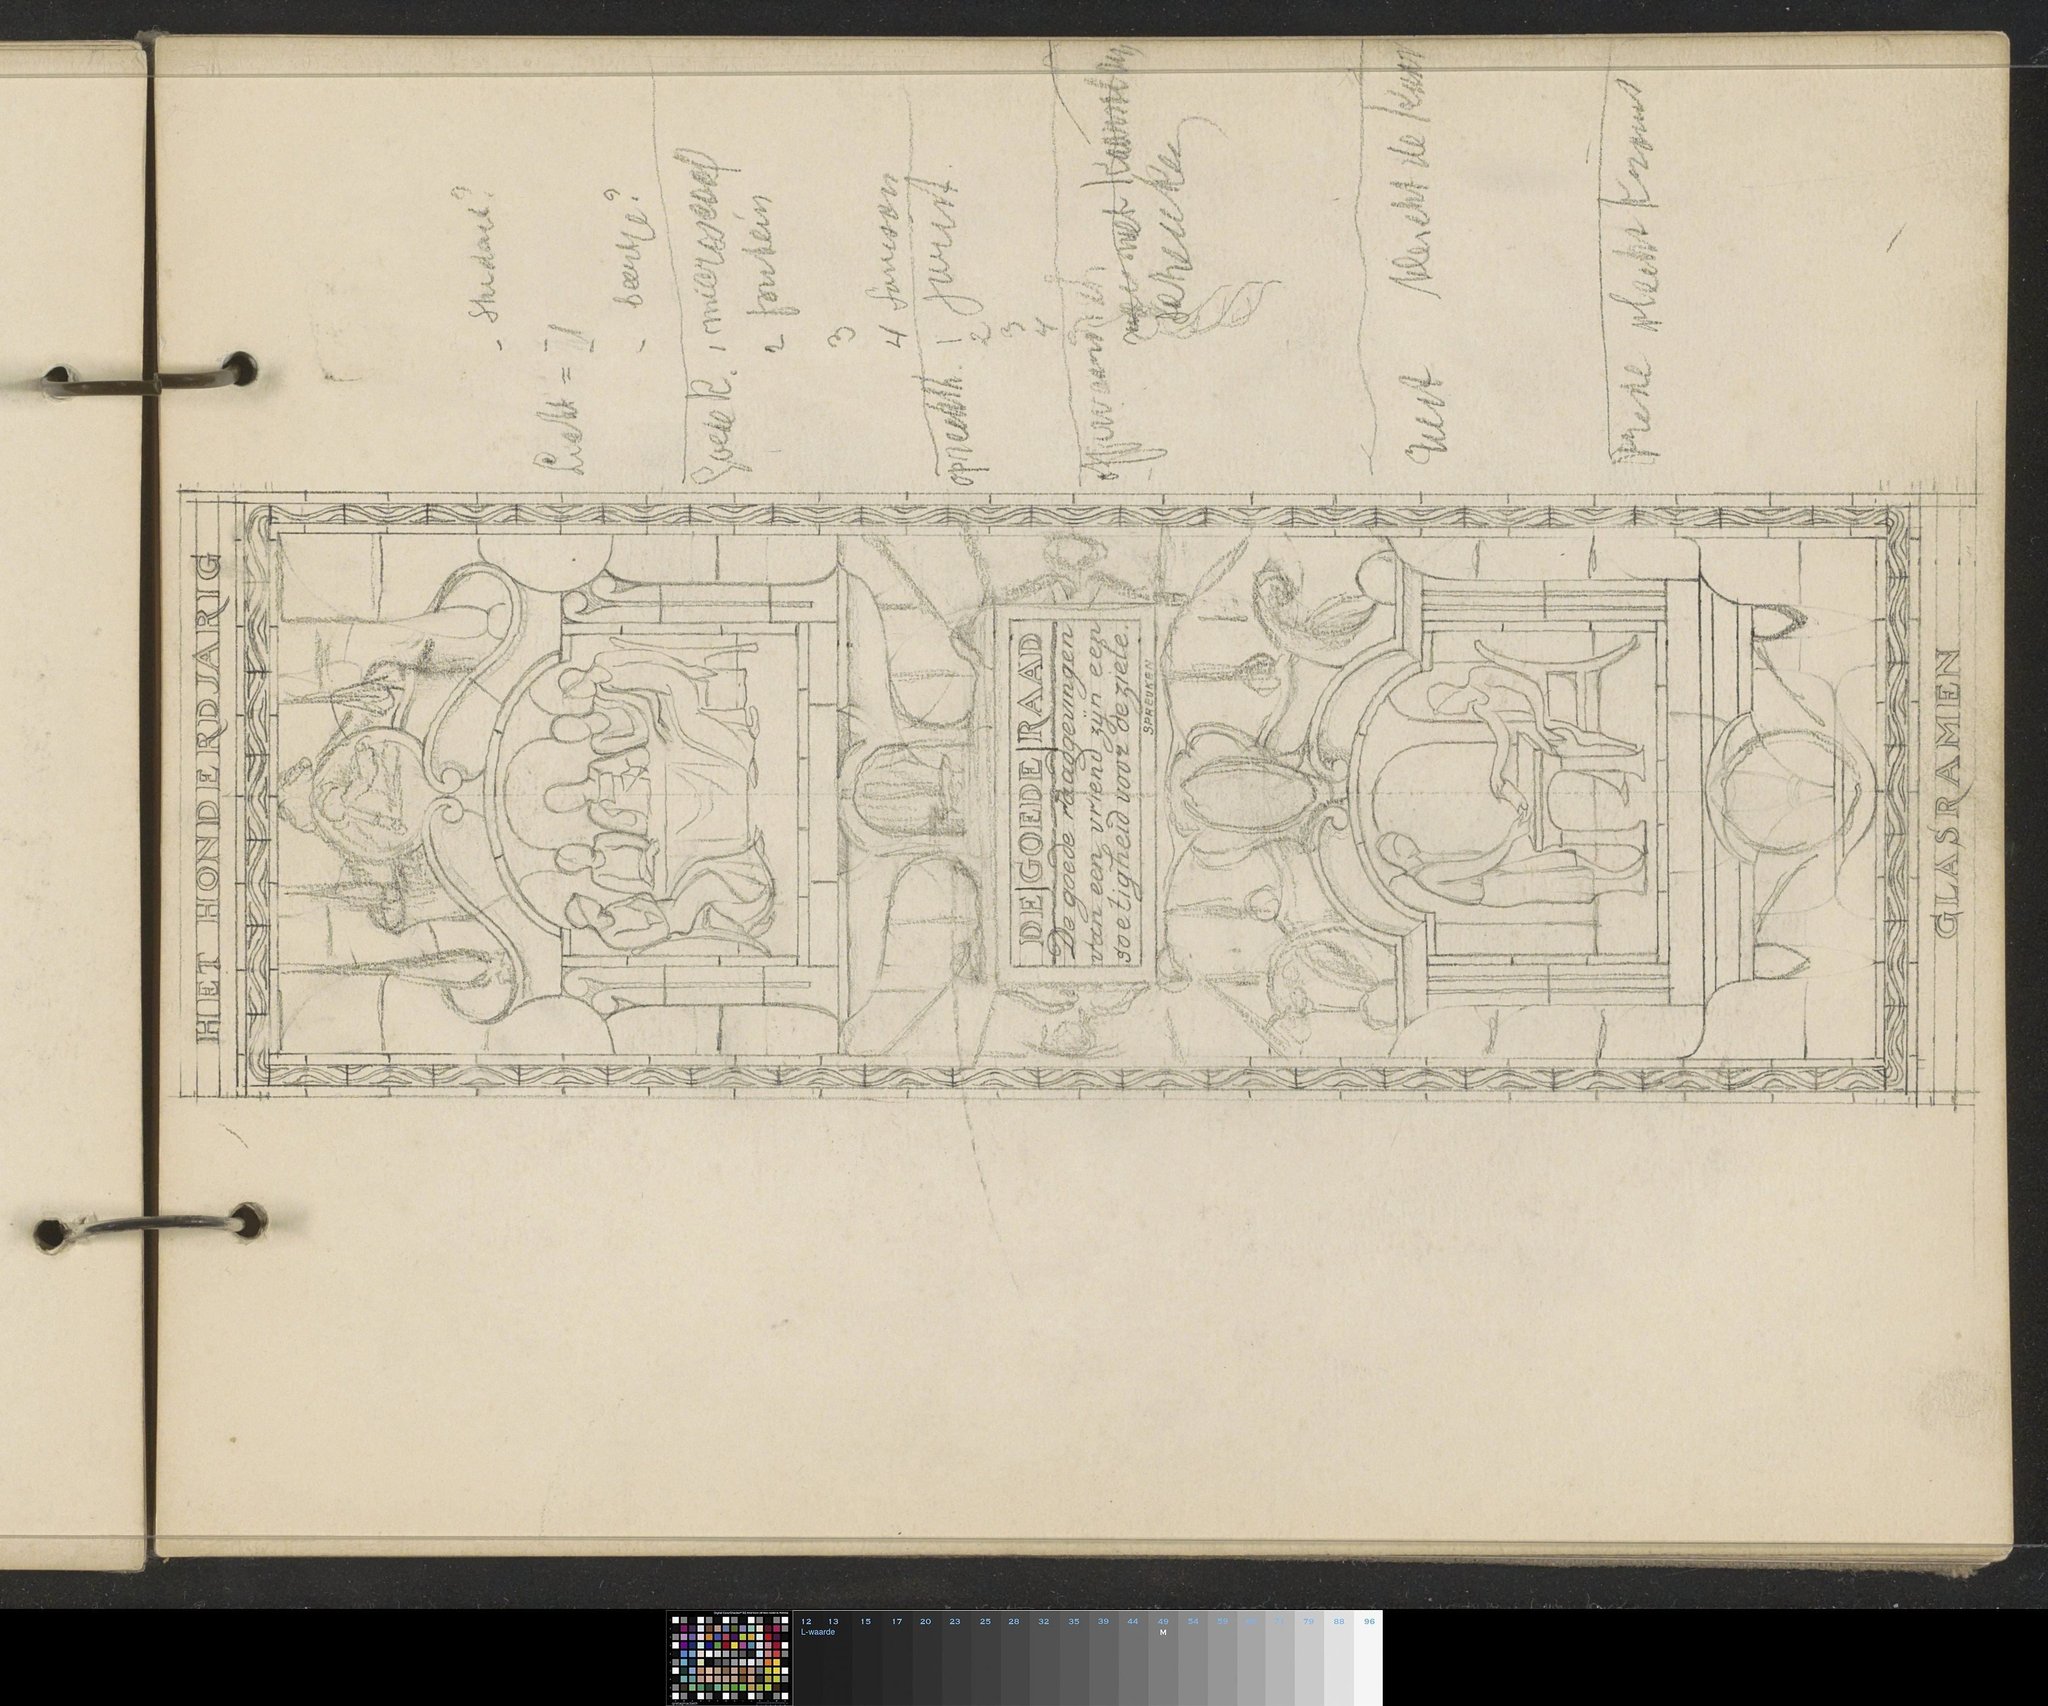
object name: sketchbook leaf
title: Ontwerp voor een glas-in-loodraam met als thema 'De Goede Raad'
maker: antoon derkinderen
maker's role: draughtsman, painter, print maker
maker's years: 1859-1925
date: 1923-1924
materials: paper, pencil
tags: work of applied art (+ glass ~ arts), abstract ideas and concepts (+ symbolical representation of concept)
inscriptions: annotation: ‘HET HONDERDJARIG/ DE GOEDE RAAD/ De goede raadgevingen/ van een vriend zijn een/ soetigeheid voor de ziele/ SPREUKEN/ GLASRAMEN/ [...]’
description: Het thema wordt uitgebeeld door middel van (onder andere) vijf figuren zittend aan een tafel waarvan één voorleest van een papier. Ontwerp voor een glas-in-loodraam voor de bestuurskamer van de Nederlandsche Handelmaatschappij te Amsterdam. Blad 5 recto uit een schetsboek met 12 bladen.